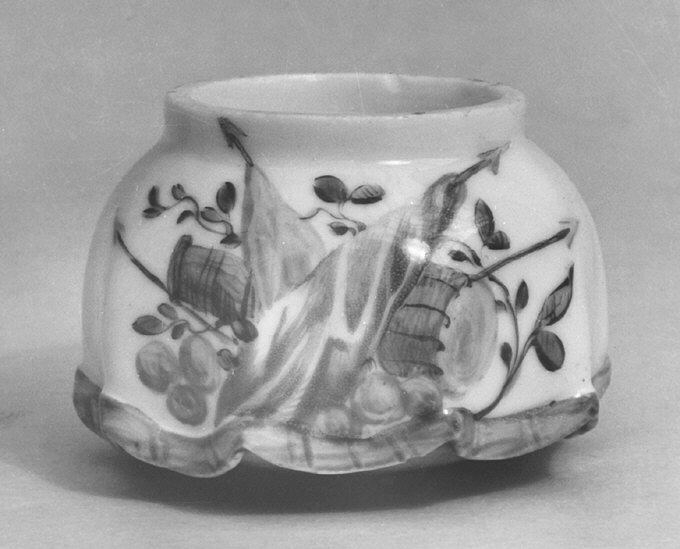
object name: snuffbox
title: Snuffbox (?) (one of a pair)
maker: mennecy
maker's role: factory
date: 1760-1770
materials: soft paste porcelain